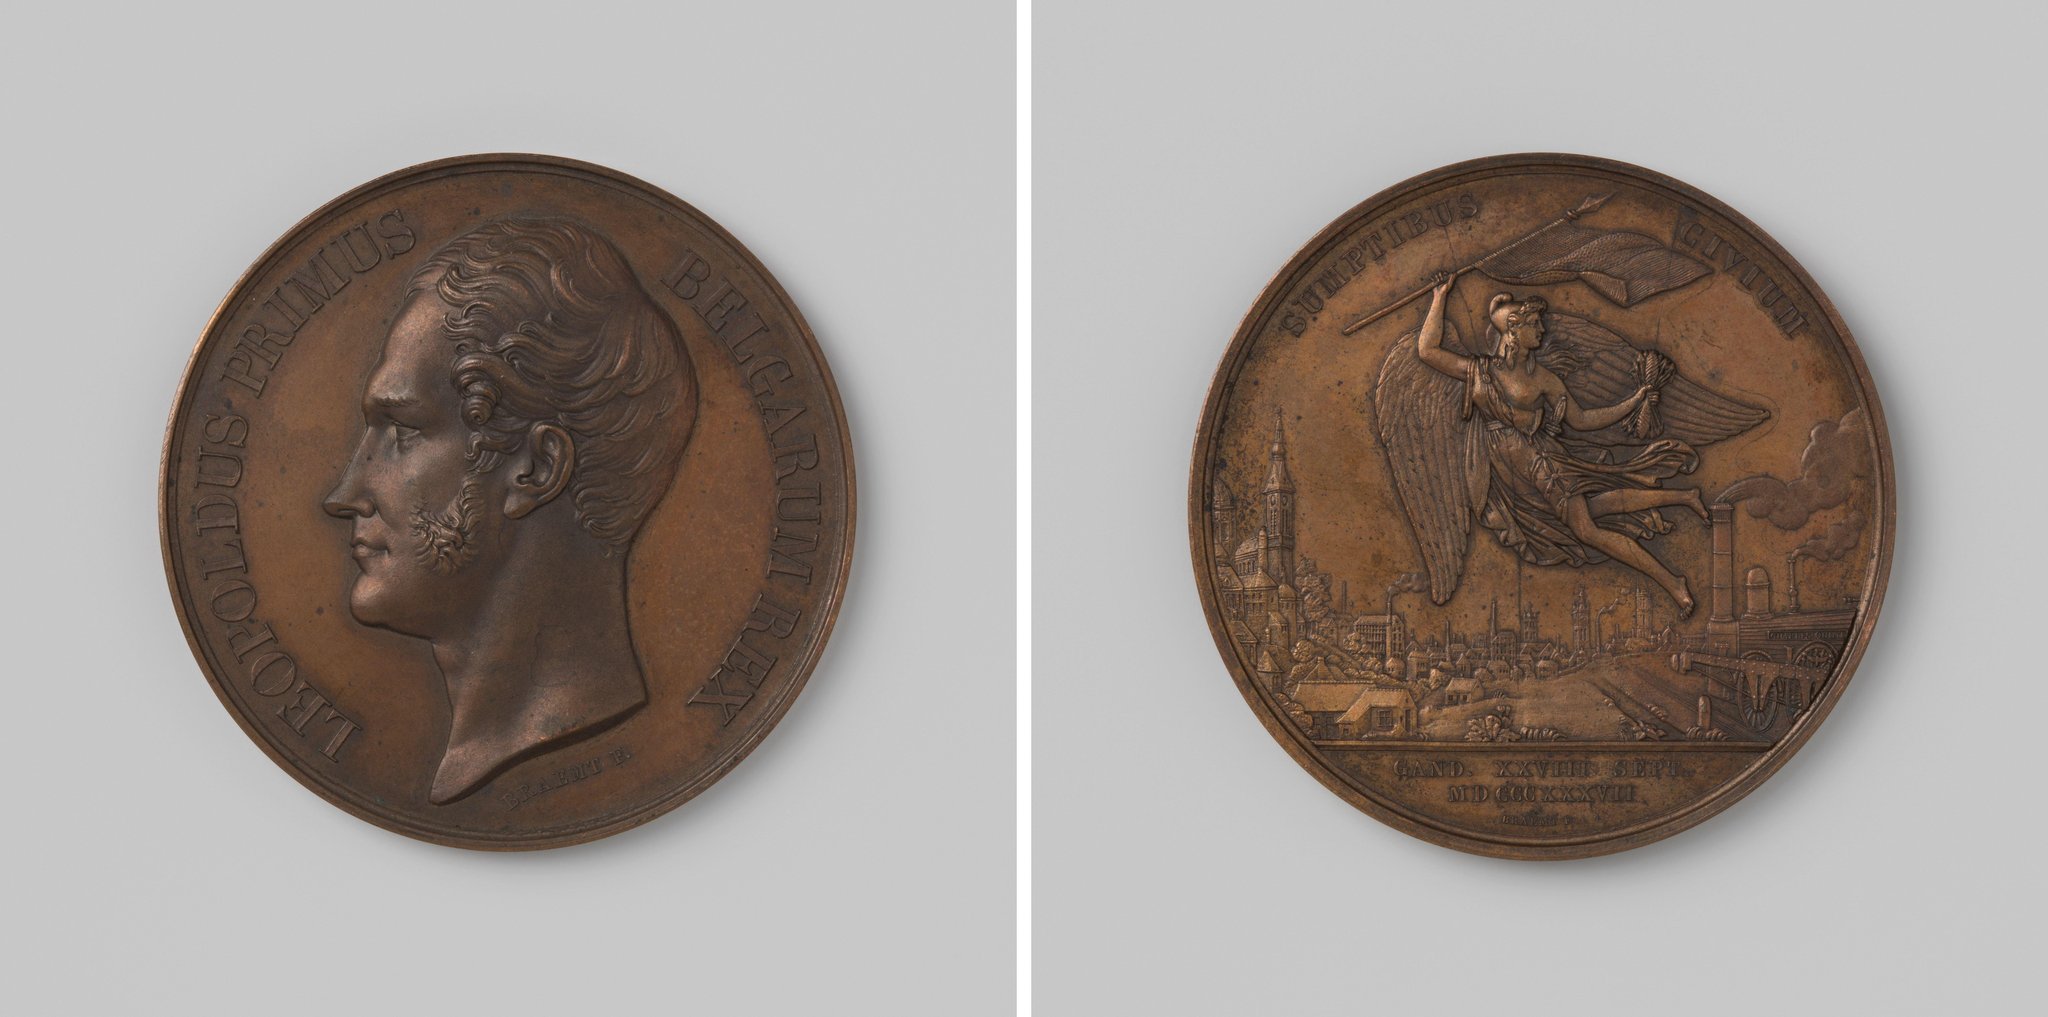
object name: history medal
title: Opening van de spoorlijn Gent-Dendermonde, ter ere van Leopold I, koning der Belgen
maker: joseph pierre braemt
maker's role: print maker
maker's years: 1796-1864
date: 1837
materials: bronze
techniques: striking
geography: brussels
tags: laeken, leopold i (koning der belgen), ghent